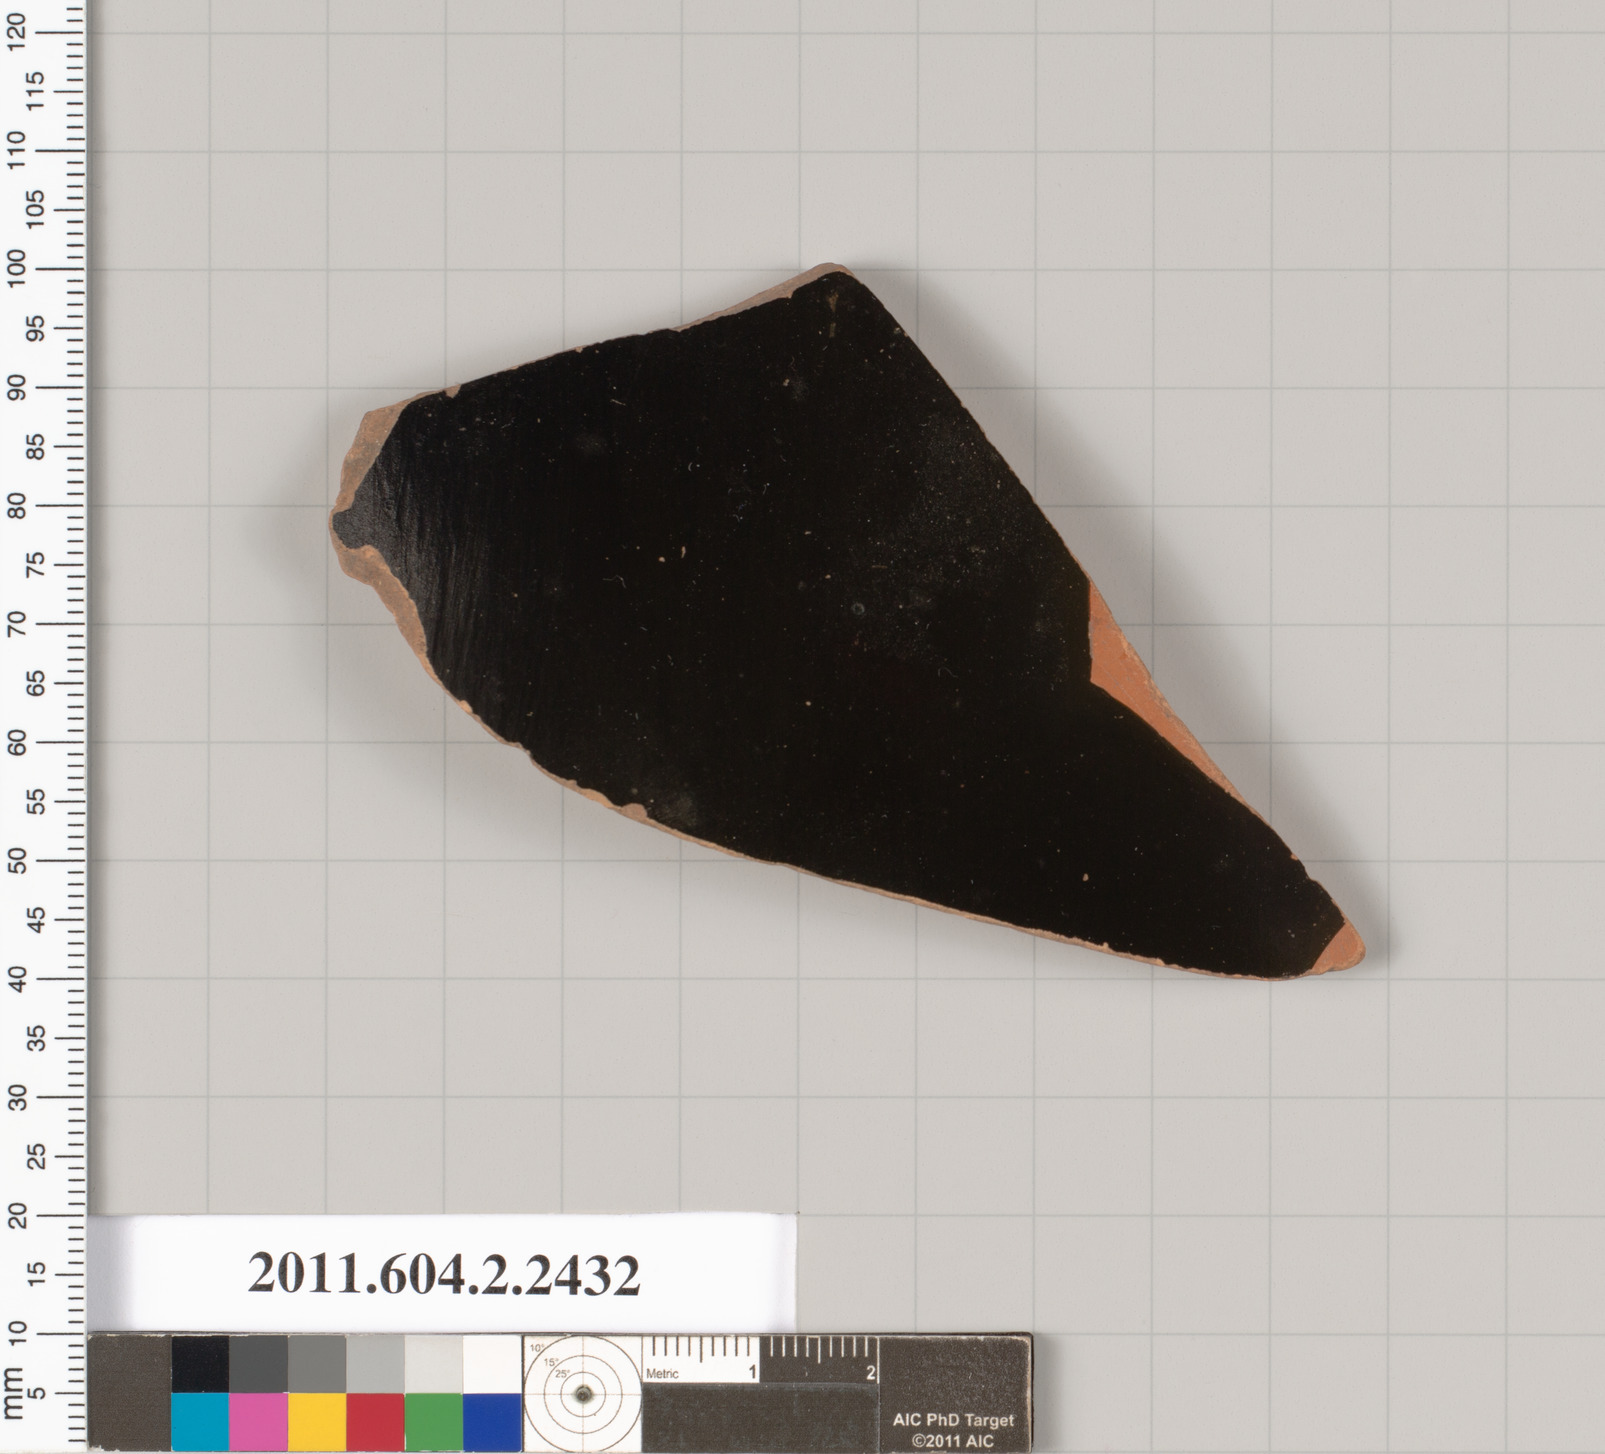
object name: amphora fragment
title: Terracotta fragment of an amphora (jar)?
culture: greek, attic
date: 490-470 BCE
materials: terracotta